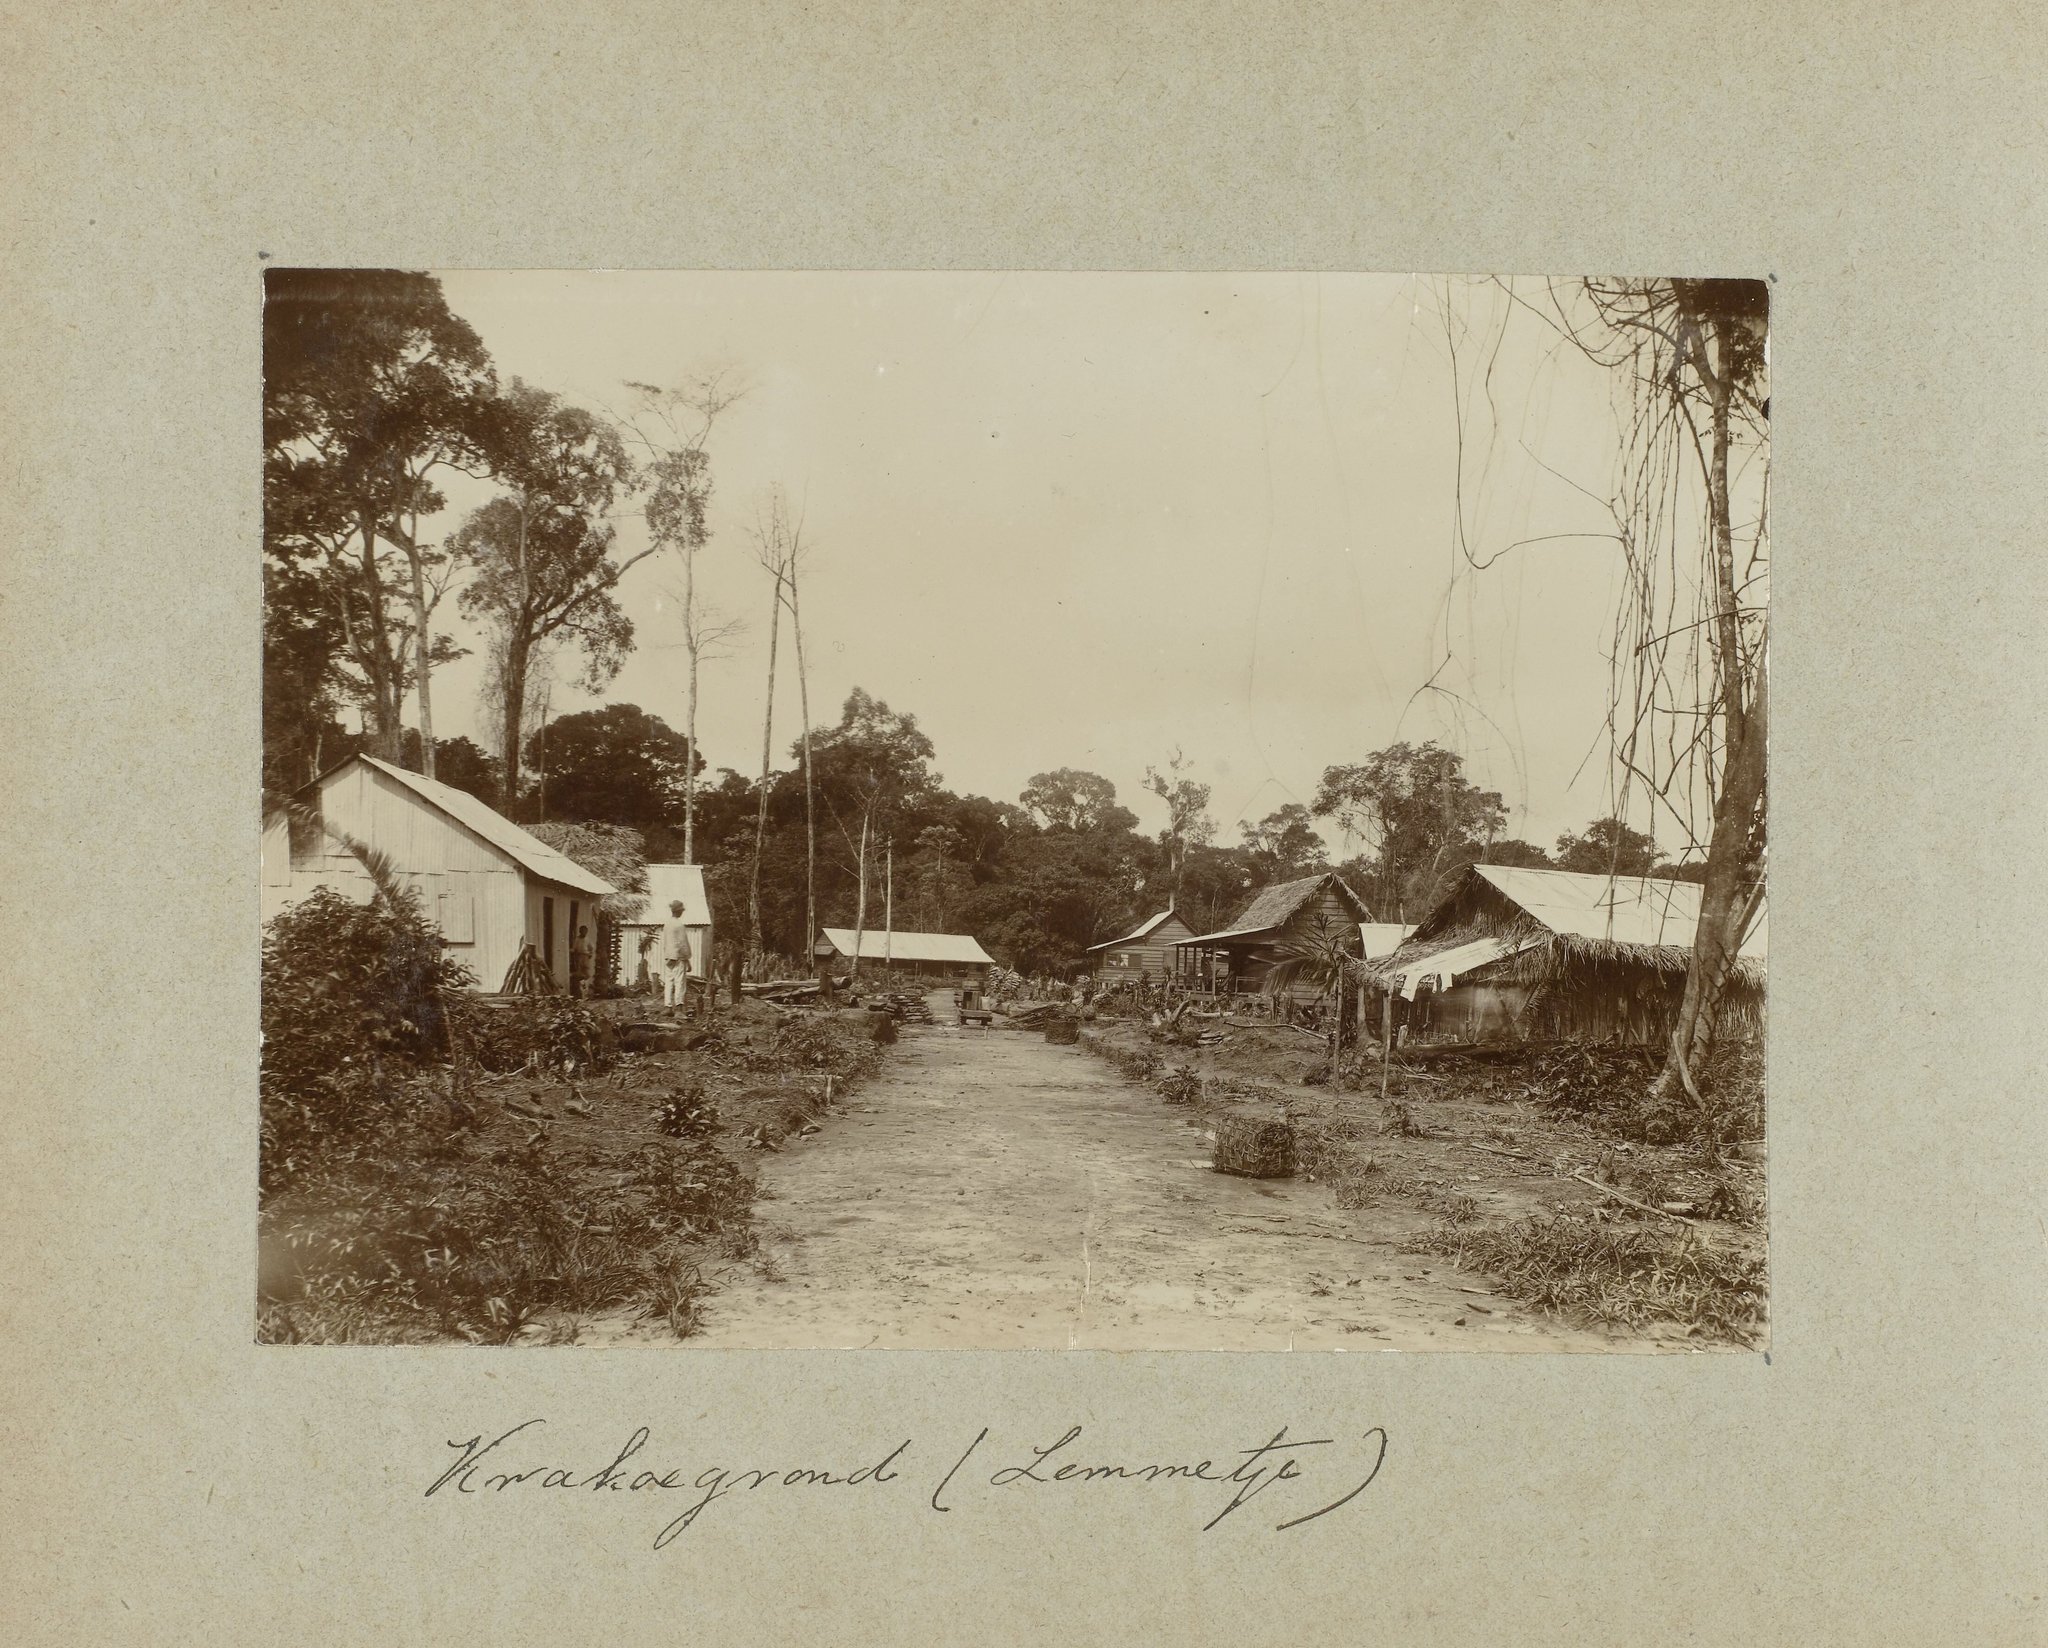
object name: photograph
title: Kwakoegrond Lemmetje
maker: Anonymous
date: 1905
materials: photographic support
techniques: gelatin silver print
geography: suriname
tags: jacob evert wesenhagen, railway, tramway; rack railway, suriname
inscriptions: inscription: ‘Kwakoegrond (Lemmetje)’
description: Gezicht in het dorp Kwakoegron. Foto in het fotoalbum over de aanleg van de Lawaspoorweg in Suriname in de jaren 1903-1912. Onderdeel van een groep objecten afkomstig van de familie Wesenhagen in Suriname.